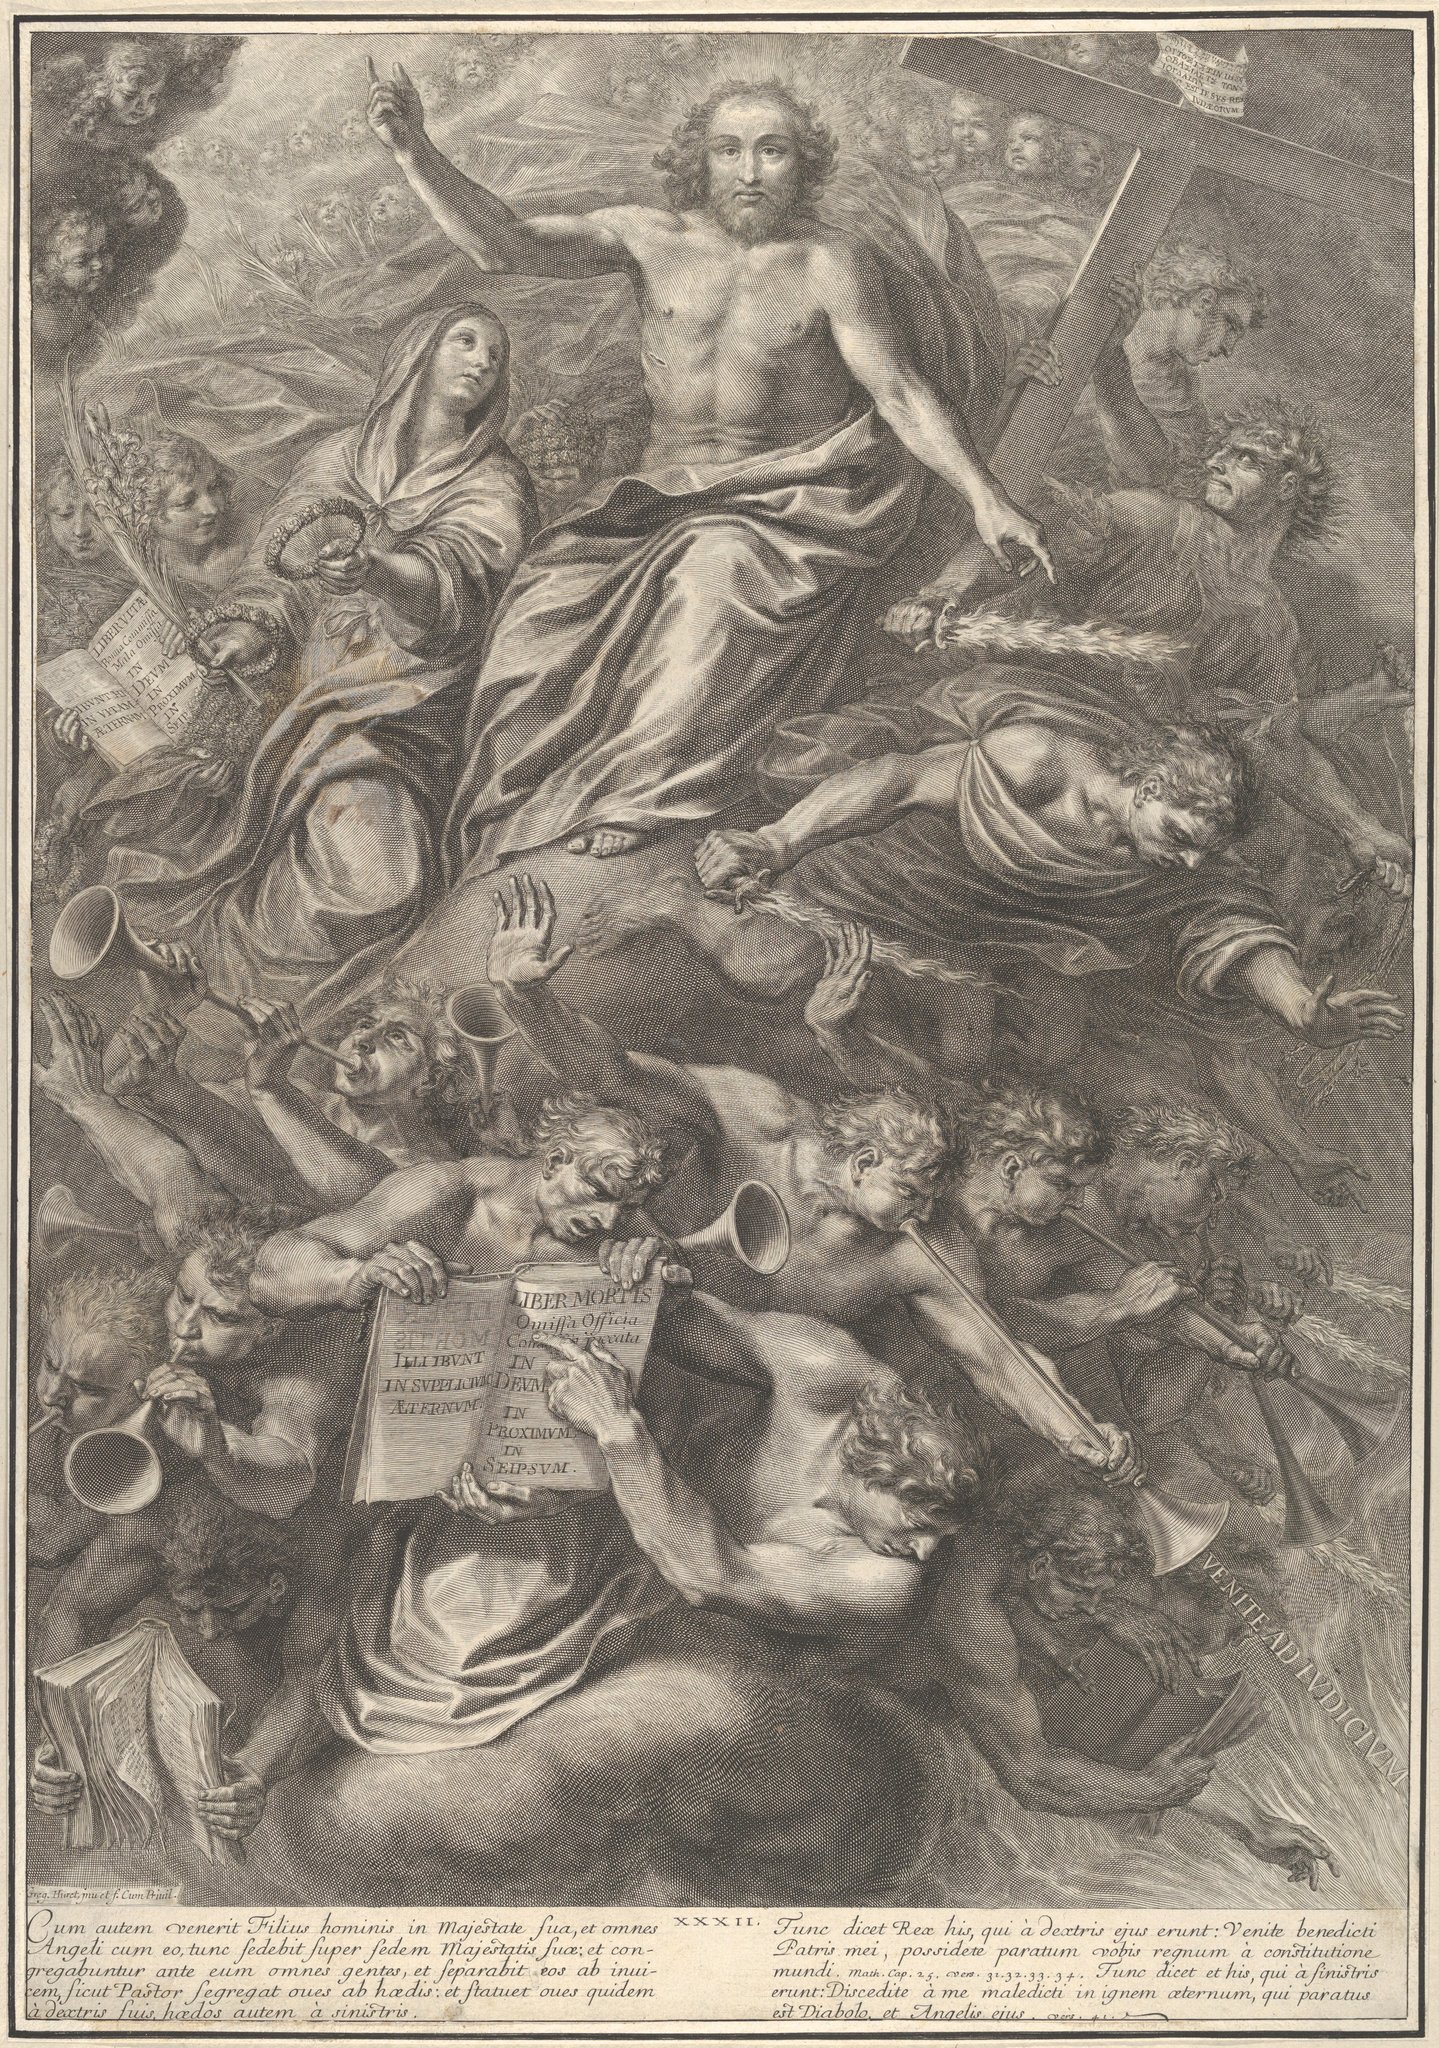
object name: print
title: The Last Judgment, from The Passion of Christ, plate 32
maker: grégoire huret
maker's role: artist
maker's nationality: french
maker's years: 1606-1670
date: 1664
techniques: engraving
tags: christ,cross,last judgement